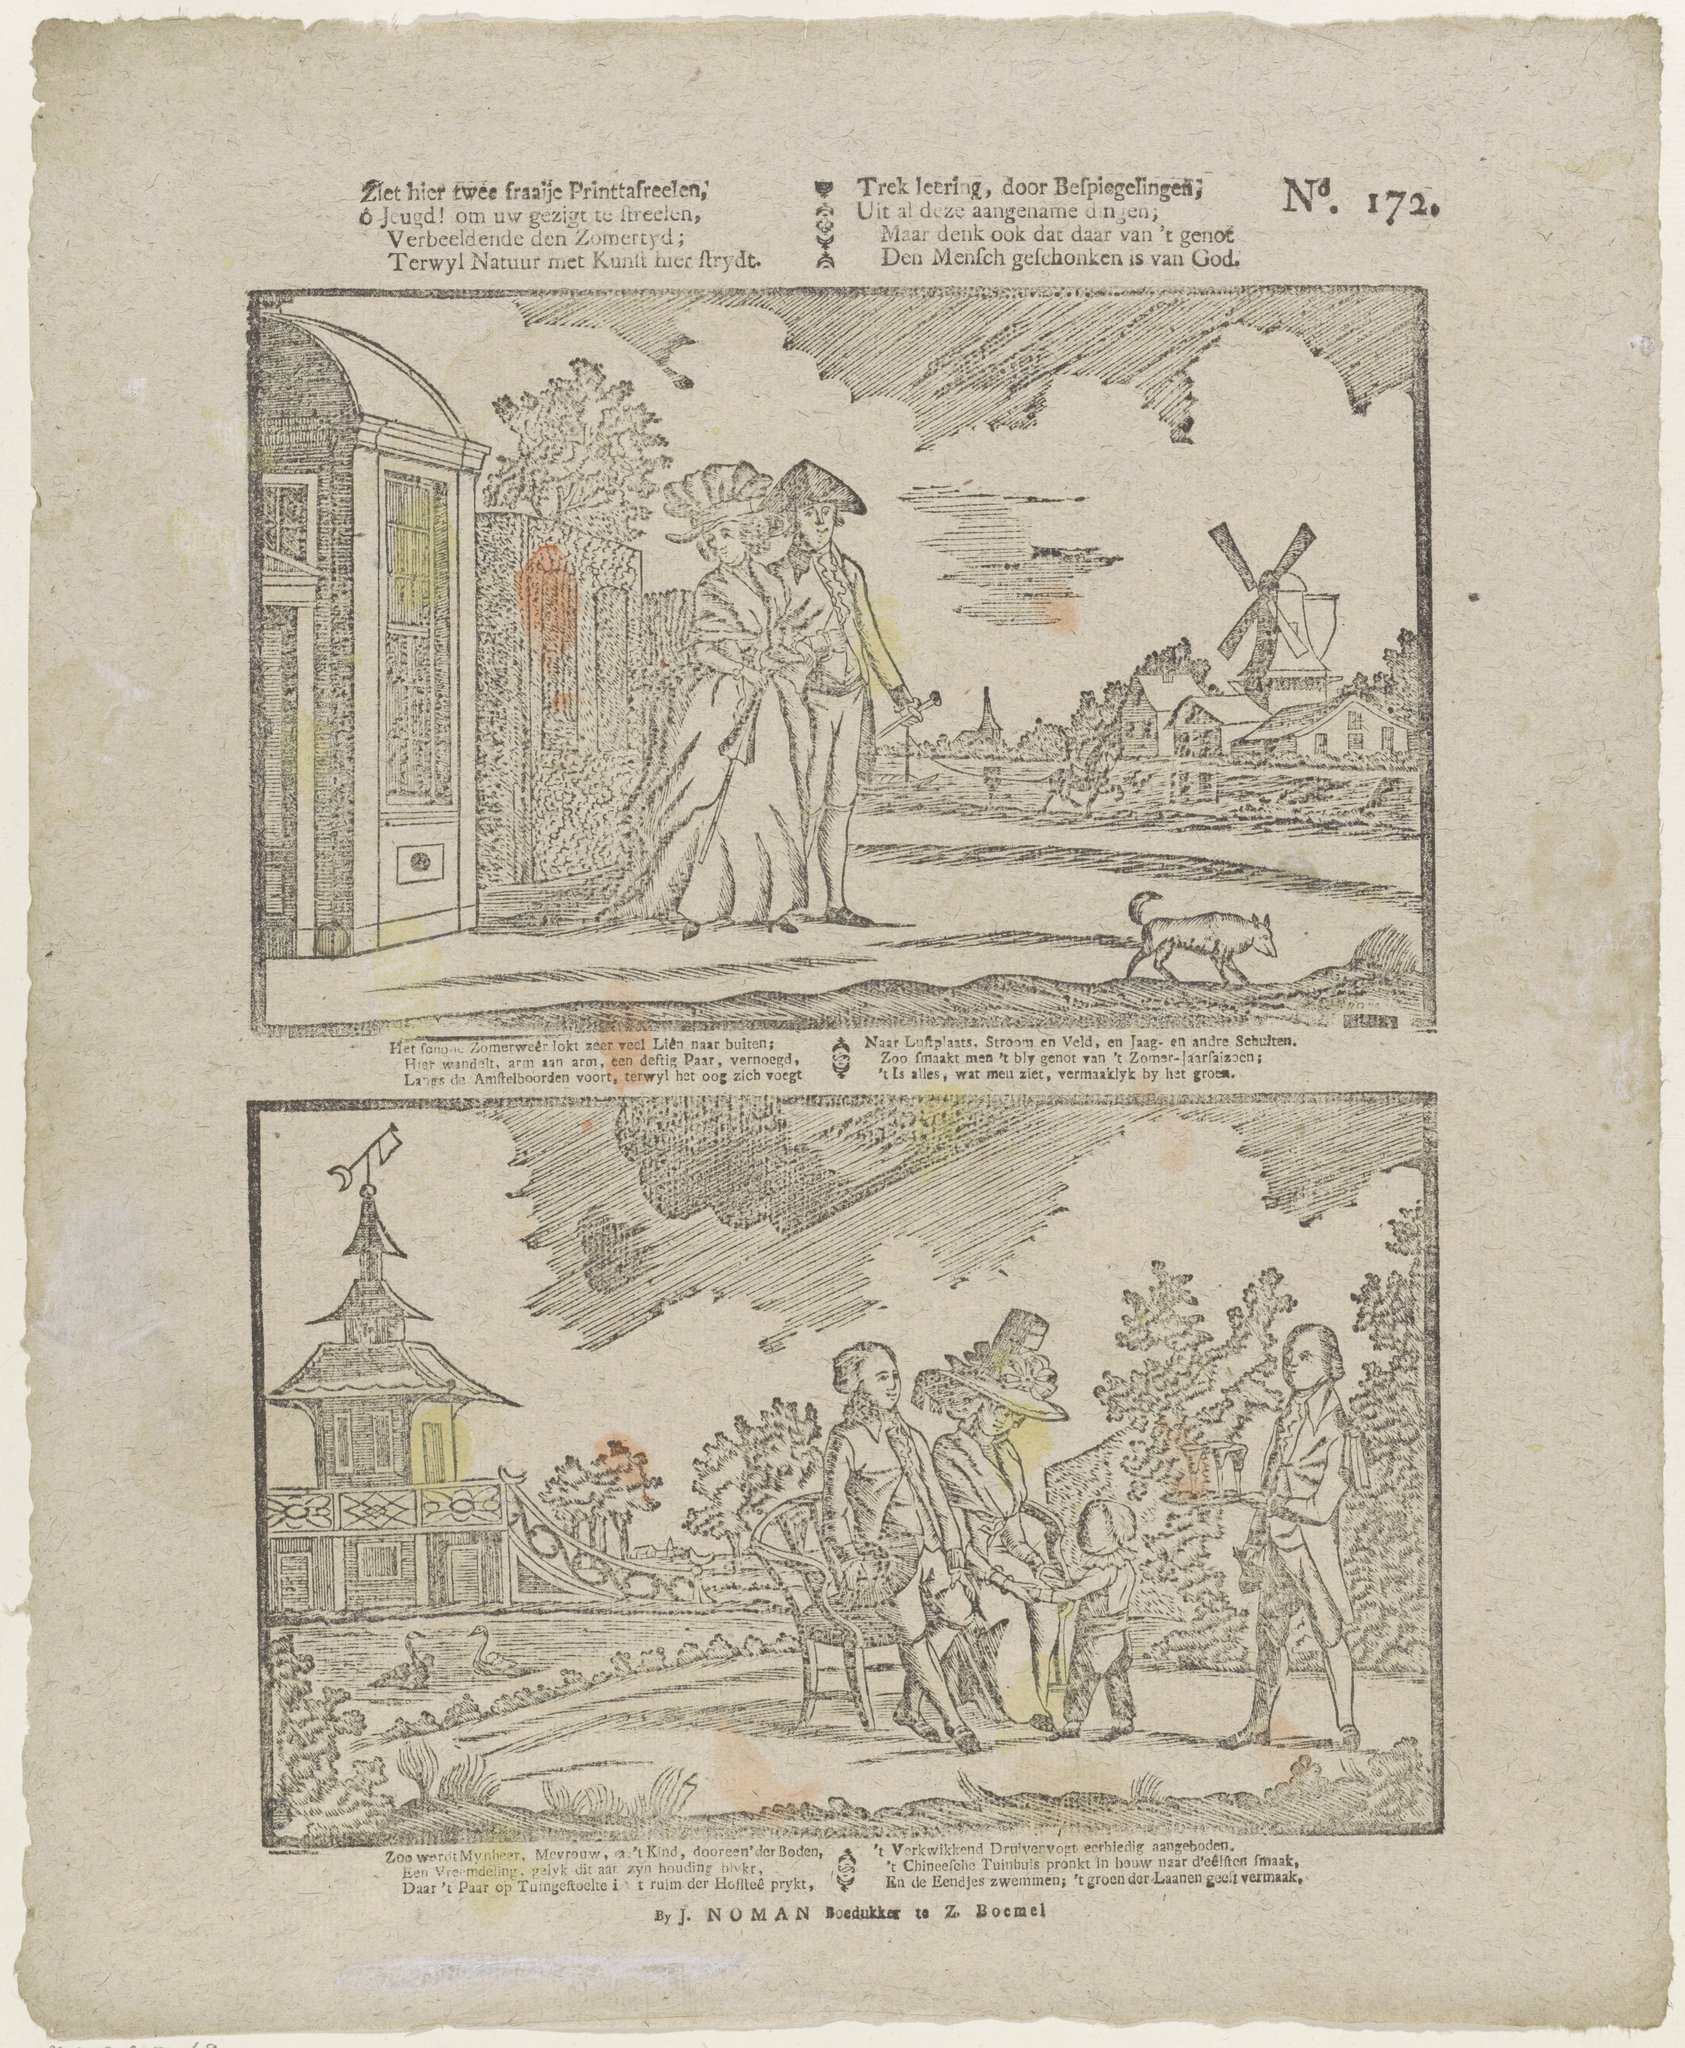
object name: print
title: Ziet hier twee fraaije printtafreelen, / ô jeugd! om uw gezigt te streelen [(...)]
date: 1806-1830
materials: paper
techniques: colour, letterpress printing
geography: zaltbommel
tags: couple of lovers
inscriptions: collector's mark: Lugt 2760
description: Blad met 2 voorstellingen. Boven: een wandelend paar. Op de achtergrond een molen. Onder: een paar met kind zittend op een bankje. Een man rechts komt drankjes brengen. Onder elke afbeelding een zesregelig vers in twee kolommen. Genummerd rechtsboven: No. 172.